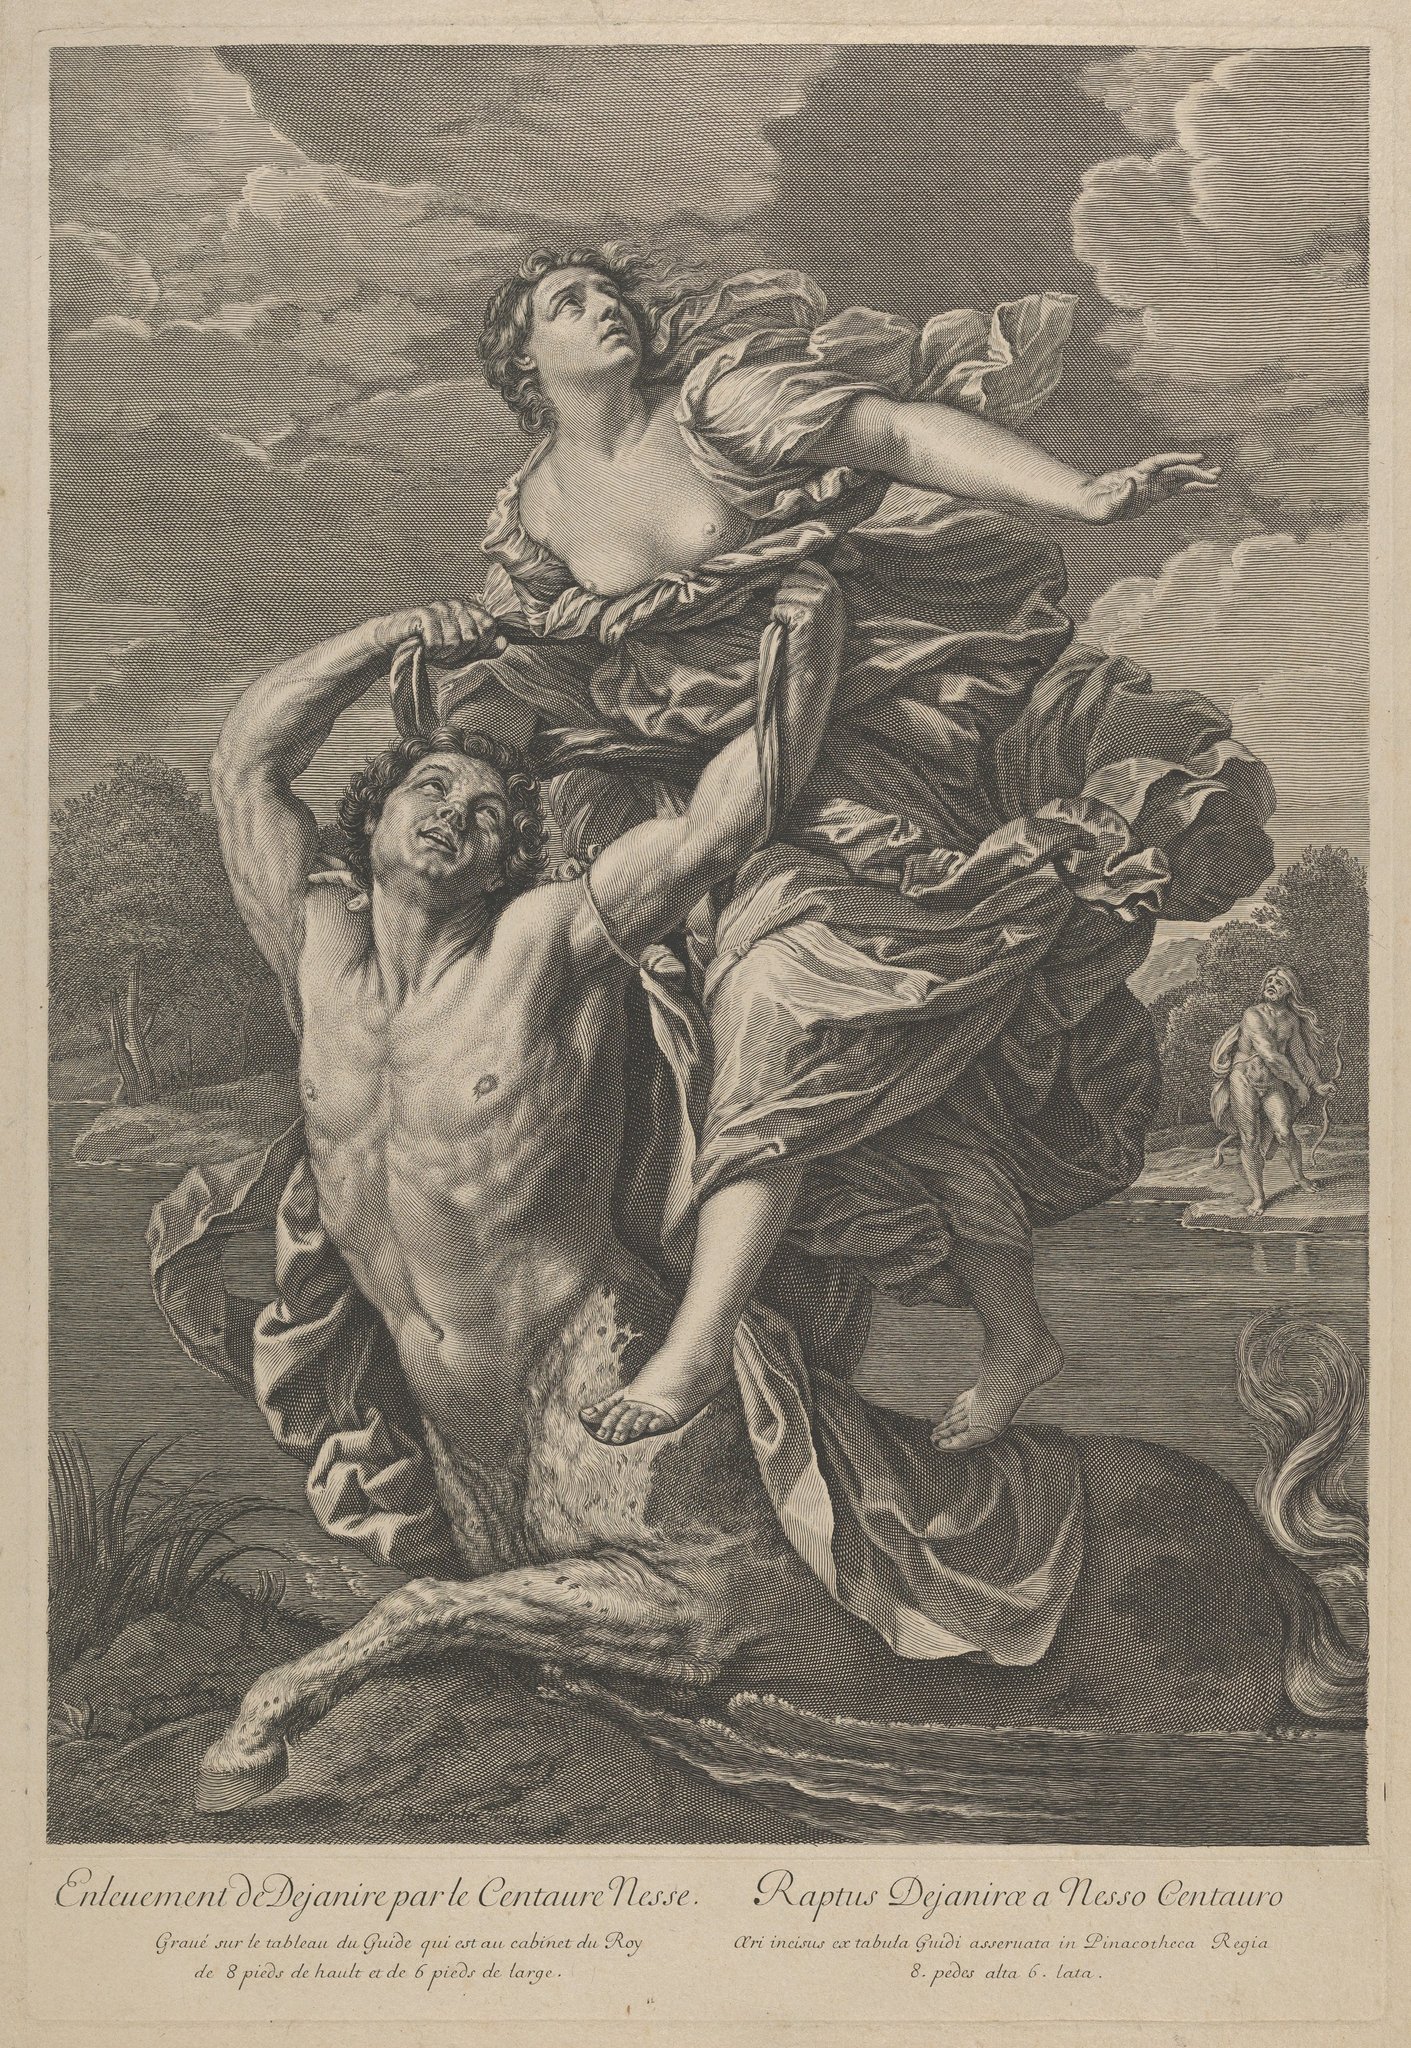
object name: print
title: Dejanira being abducted by the centaur Nessos, a man with bow and arrow at right, after Reni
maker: Anonymous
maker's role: artist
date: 1800-1850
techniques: engraving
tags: men,women,centaurs